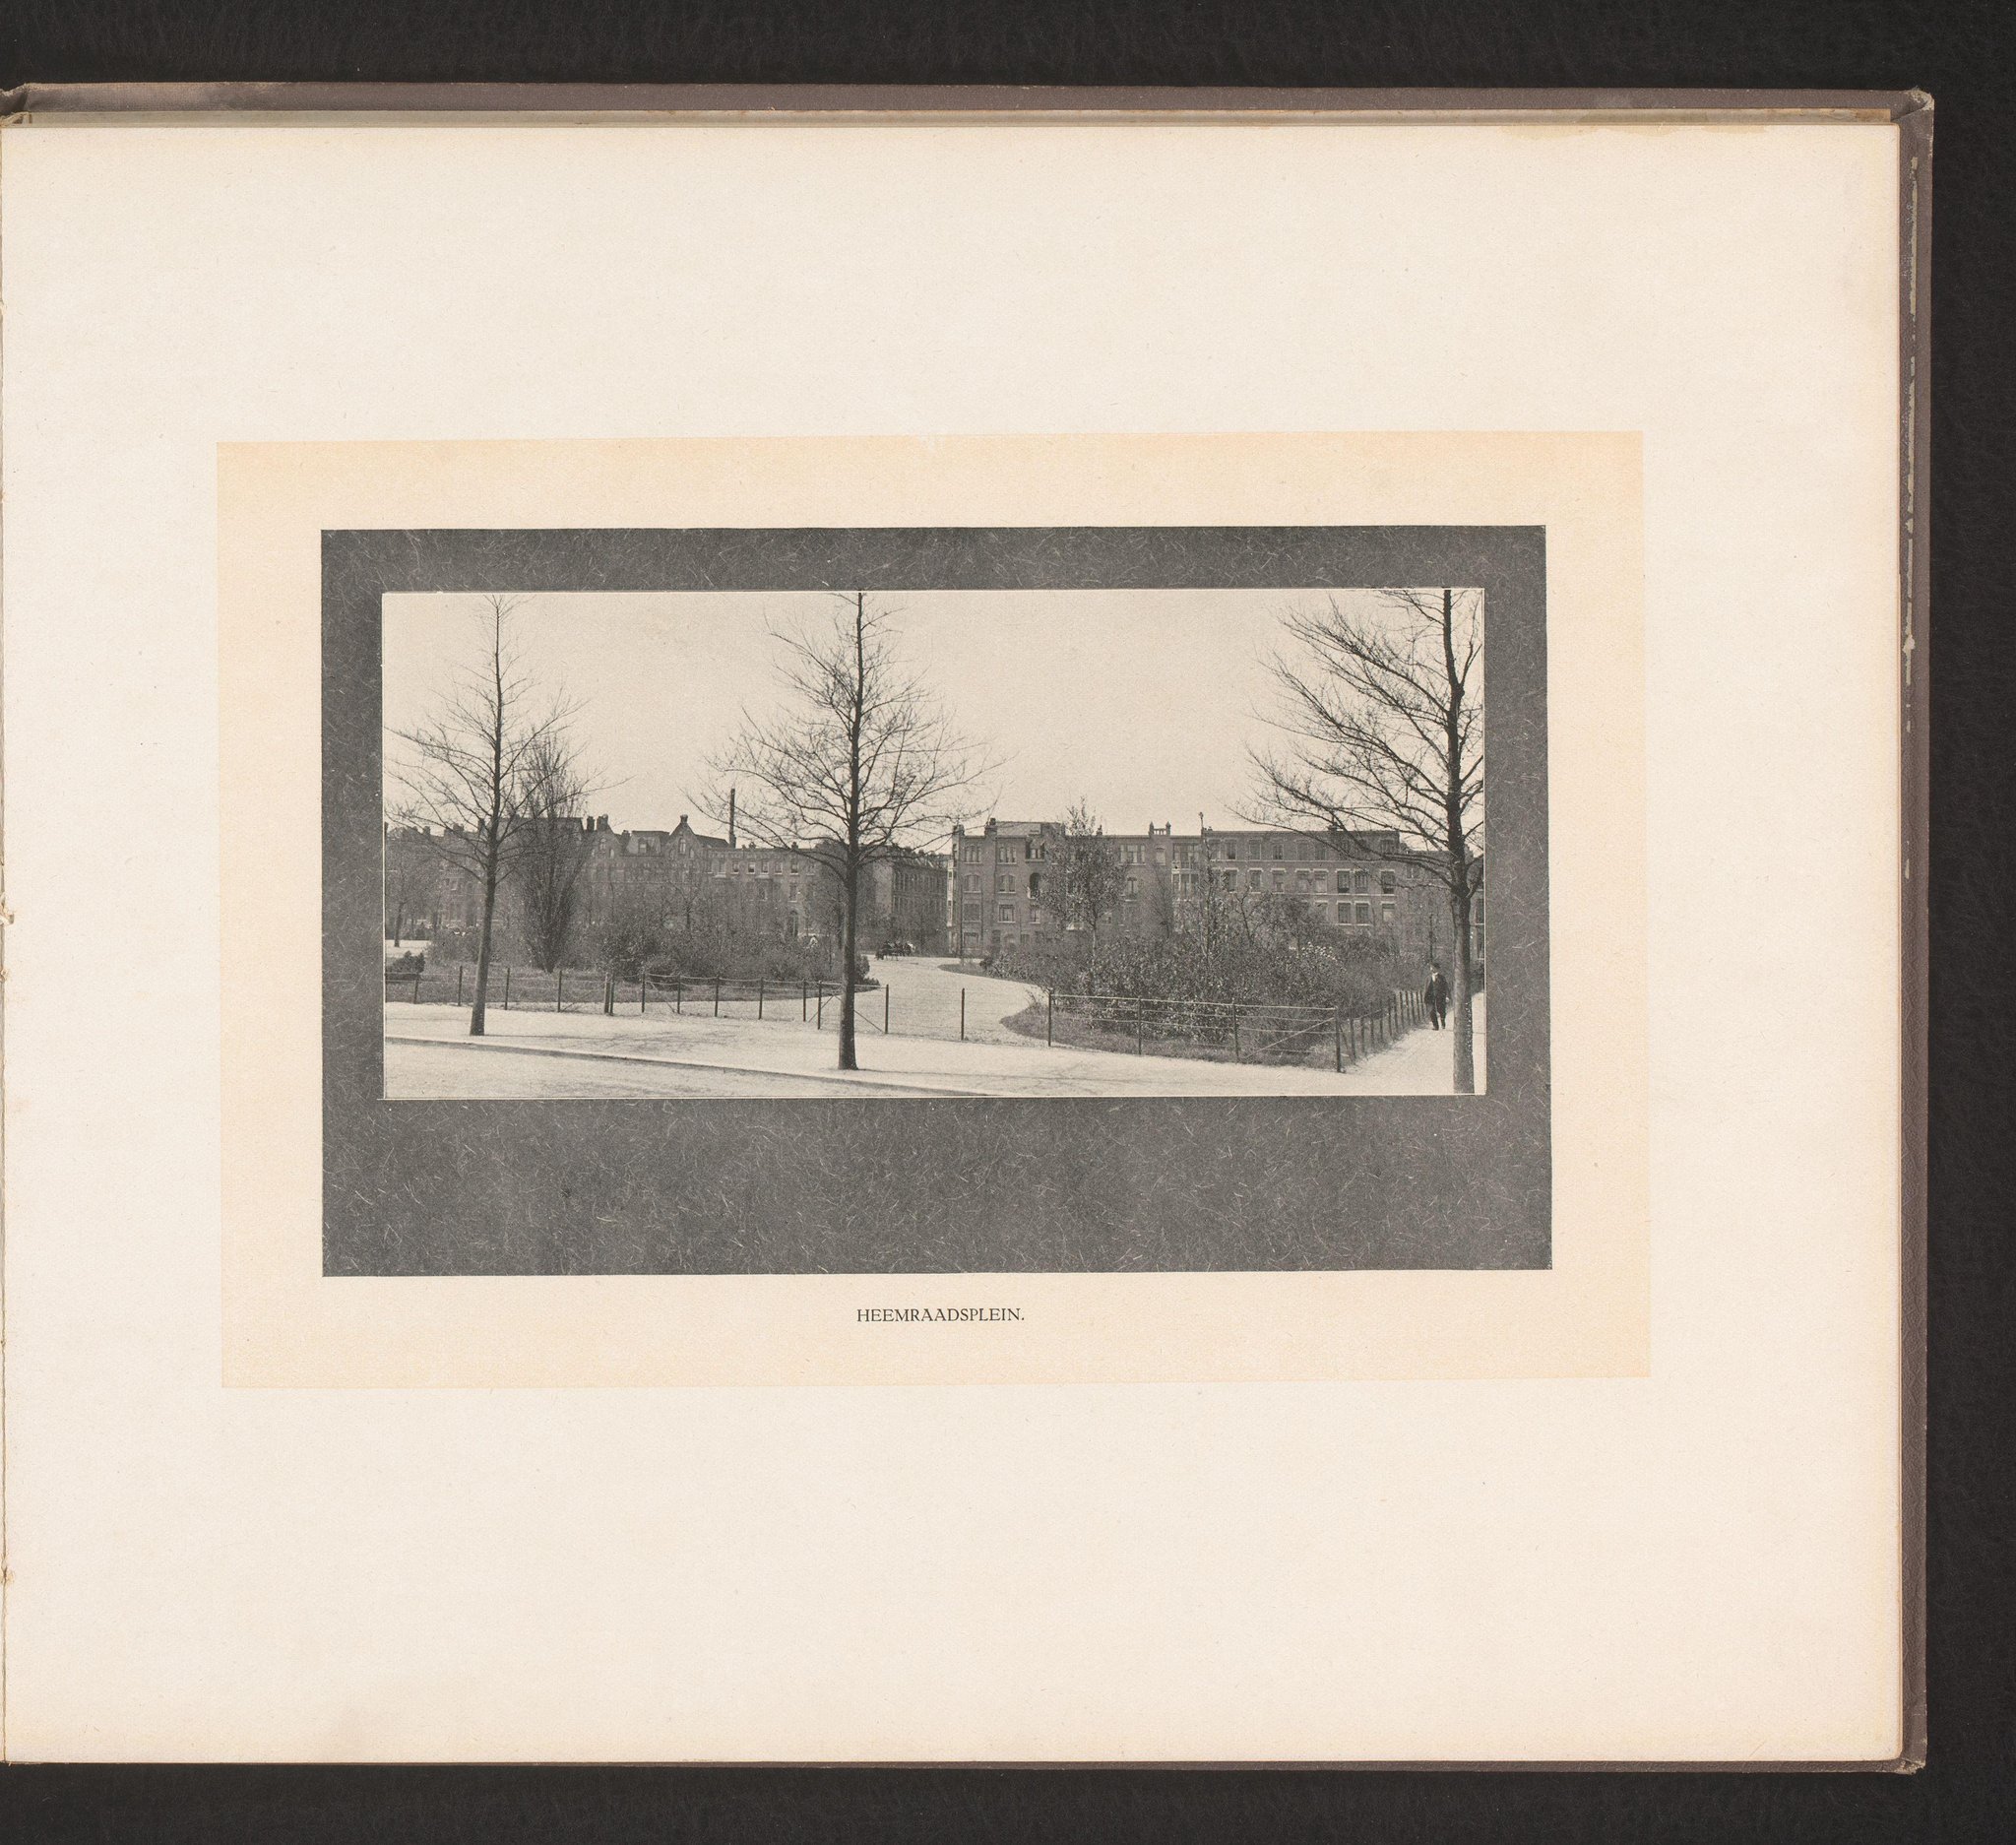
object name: album leaf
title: Gezicht op het Heemraadsplein te Rotterdam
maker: Anonymous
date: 1908-1913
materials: paper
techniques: autotype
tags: square, place, circus, etc. (+ city(-scape) with figures, staffage), rotterdam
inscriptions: inscription: ‘Heemraadsplein’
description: Deze prent maakt deel uit van een album.